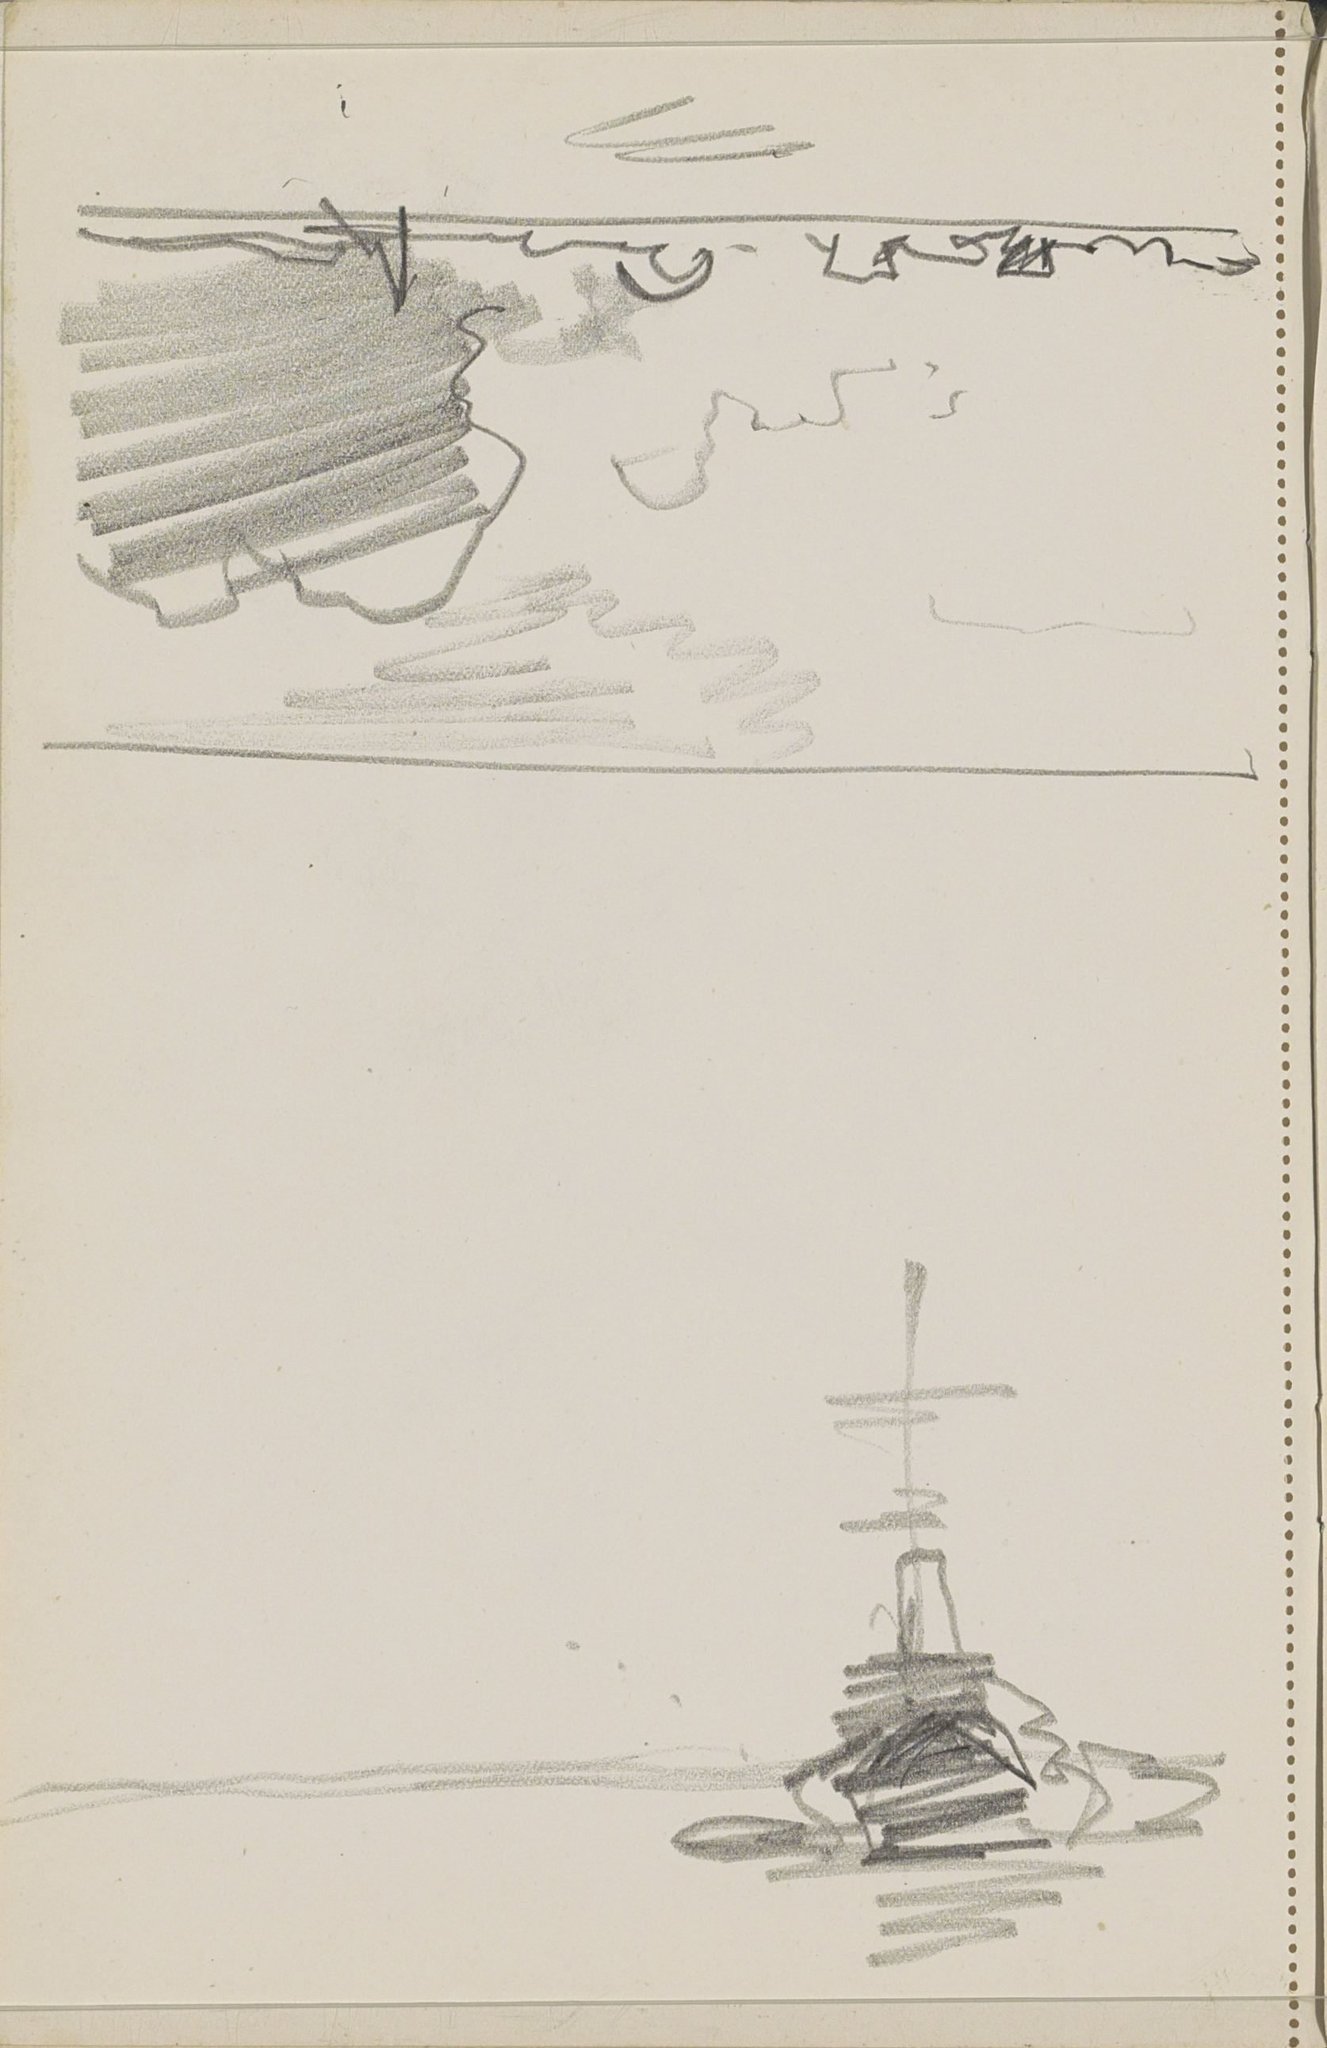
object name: sketchbook leaf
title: Zeilschip op open water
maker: cornelis vreedenburgh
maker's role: draughtsman, print maker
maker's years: 1880-1946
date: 1890-1946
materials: paper, pencil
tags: sailing-ship, sailing-boat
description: Tevens een studie van een (zee)landschap. Blad 54 verso uit een schetsboek met 61 bladen.